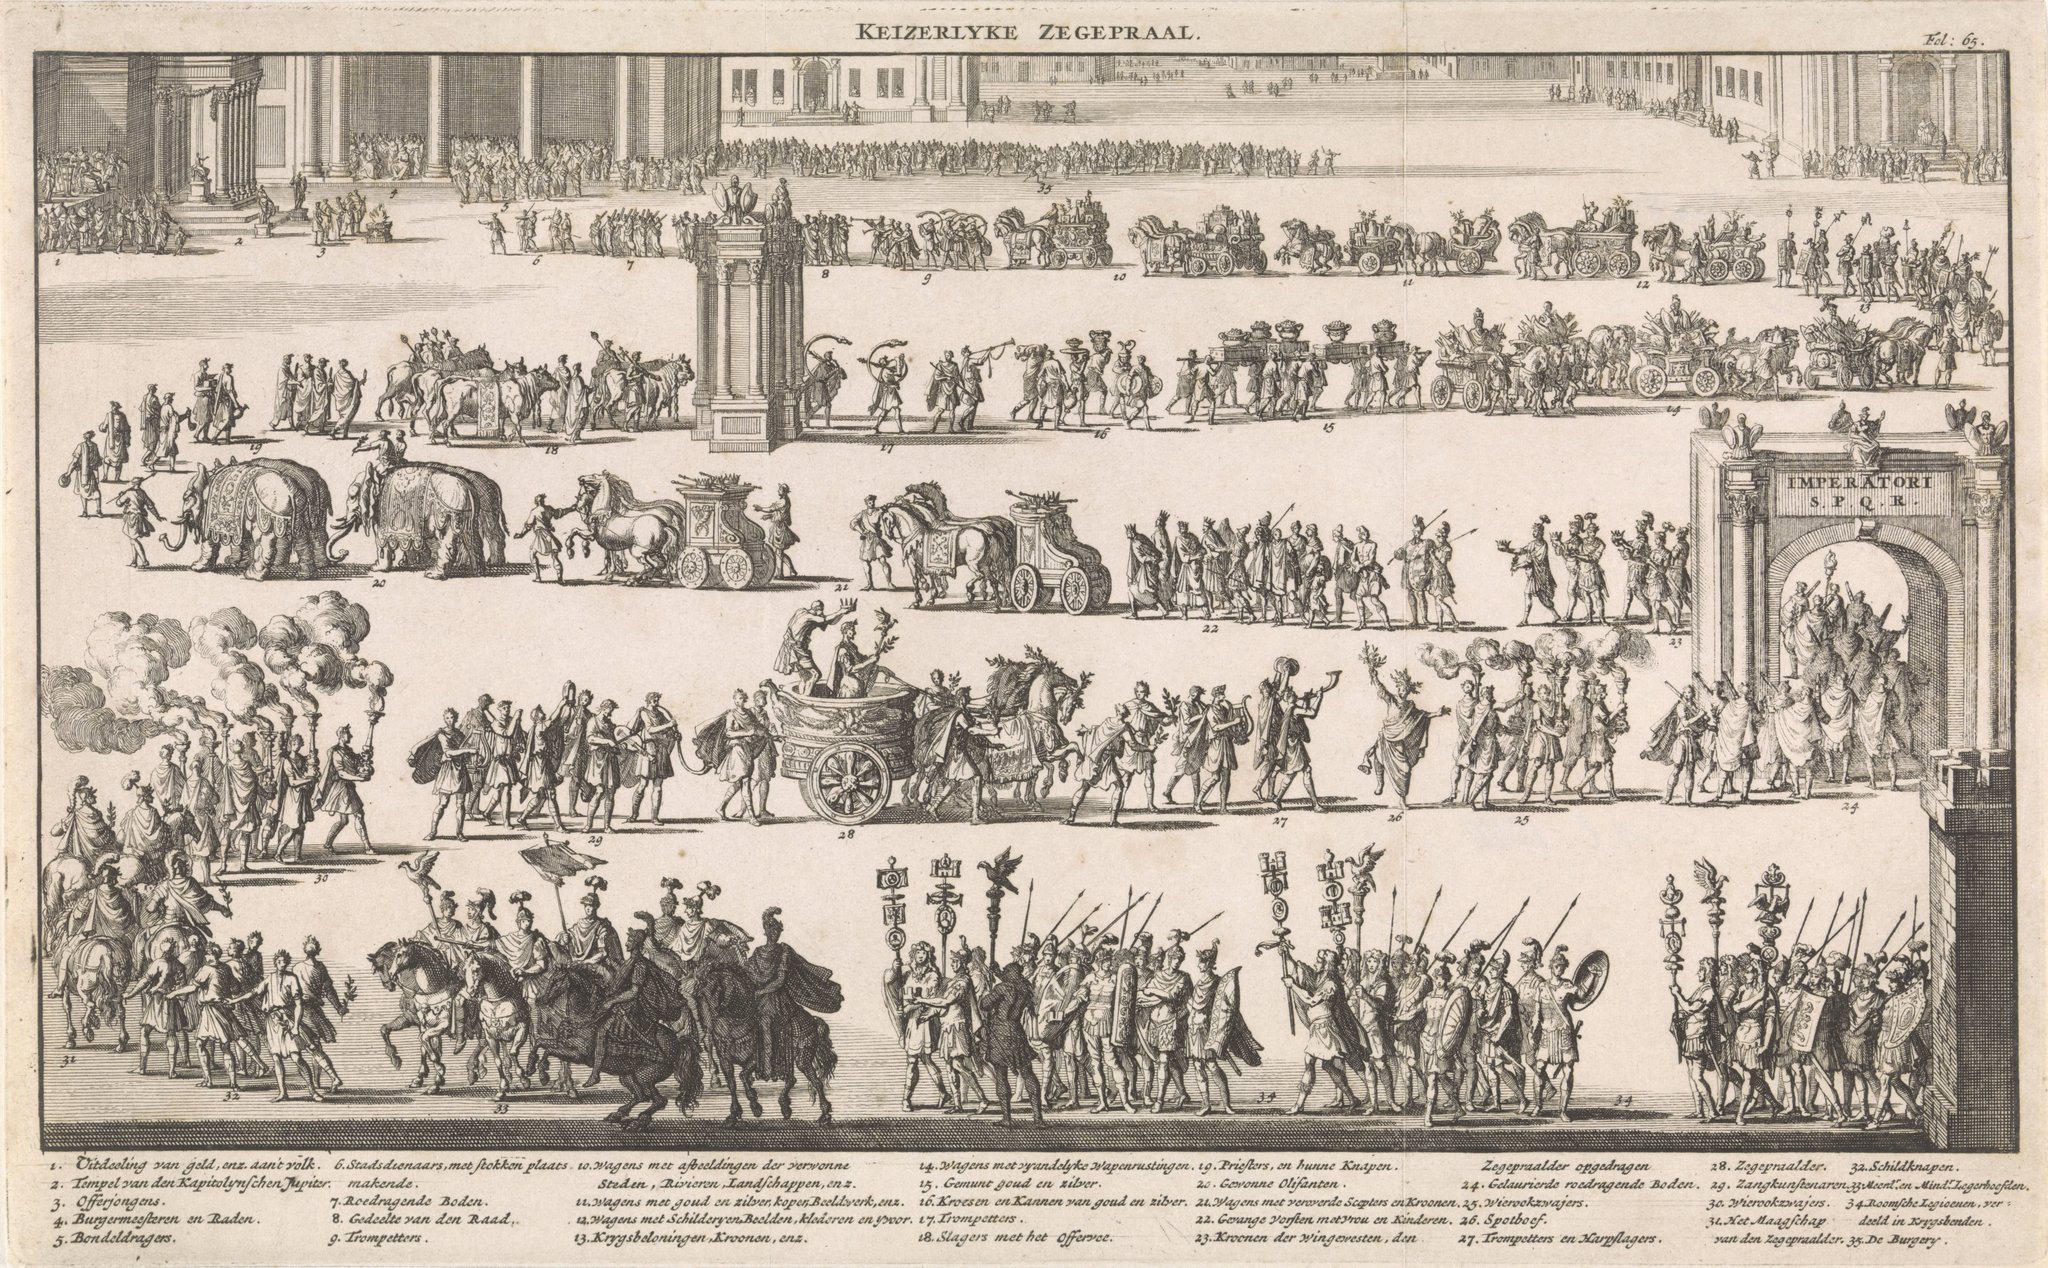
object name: print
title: Keizerlijke triomftocht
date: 1697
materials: paper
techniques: etching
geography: utrecht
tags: conqueror triumphing, triumphal entry of victor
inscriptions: collector's mark: Lugt 2228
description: Illustratie uit: Bogaert, Abraham. De roomsche monarchy, vertoont in de muntbeelden der westersche en oostersche keizeren. Utrecht: François Halma en Willem van de Water, 1697.